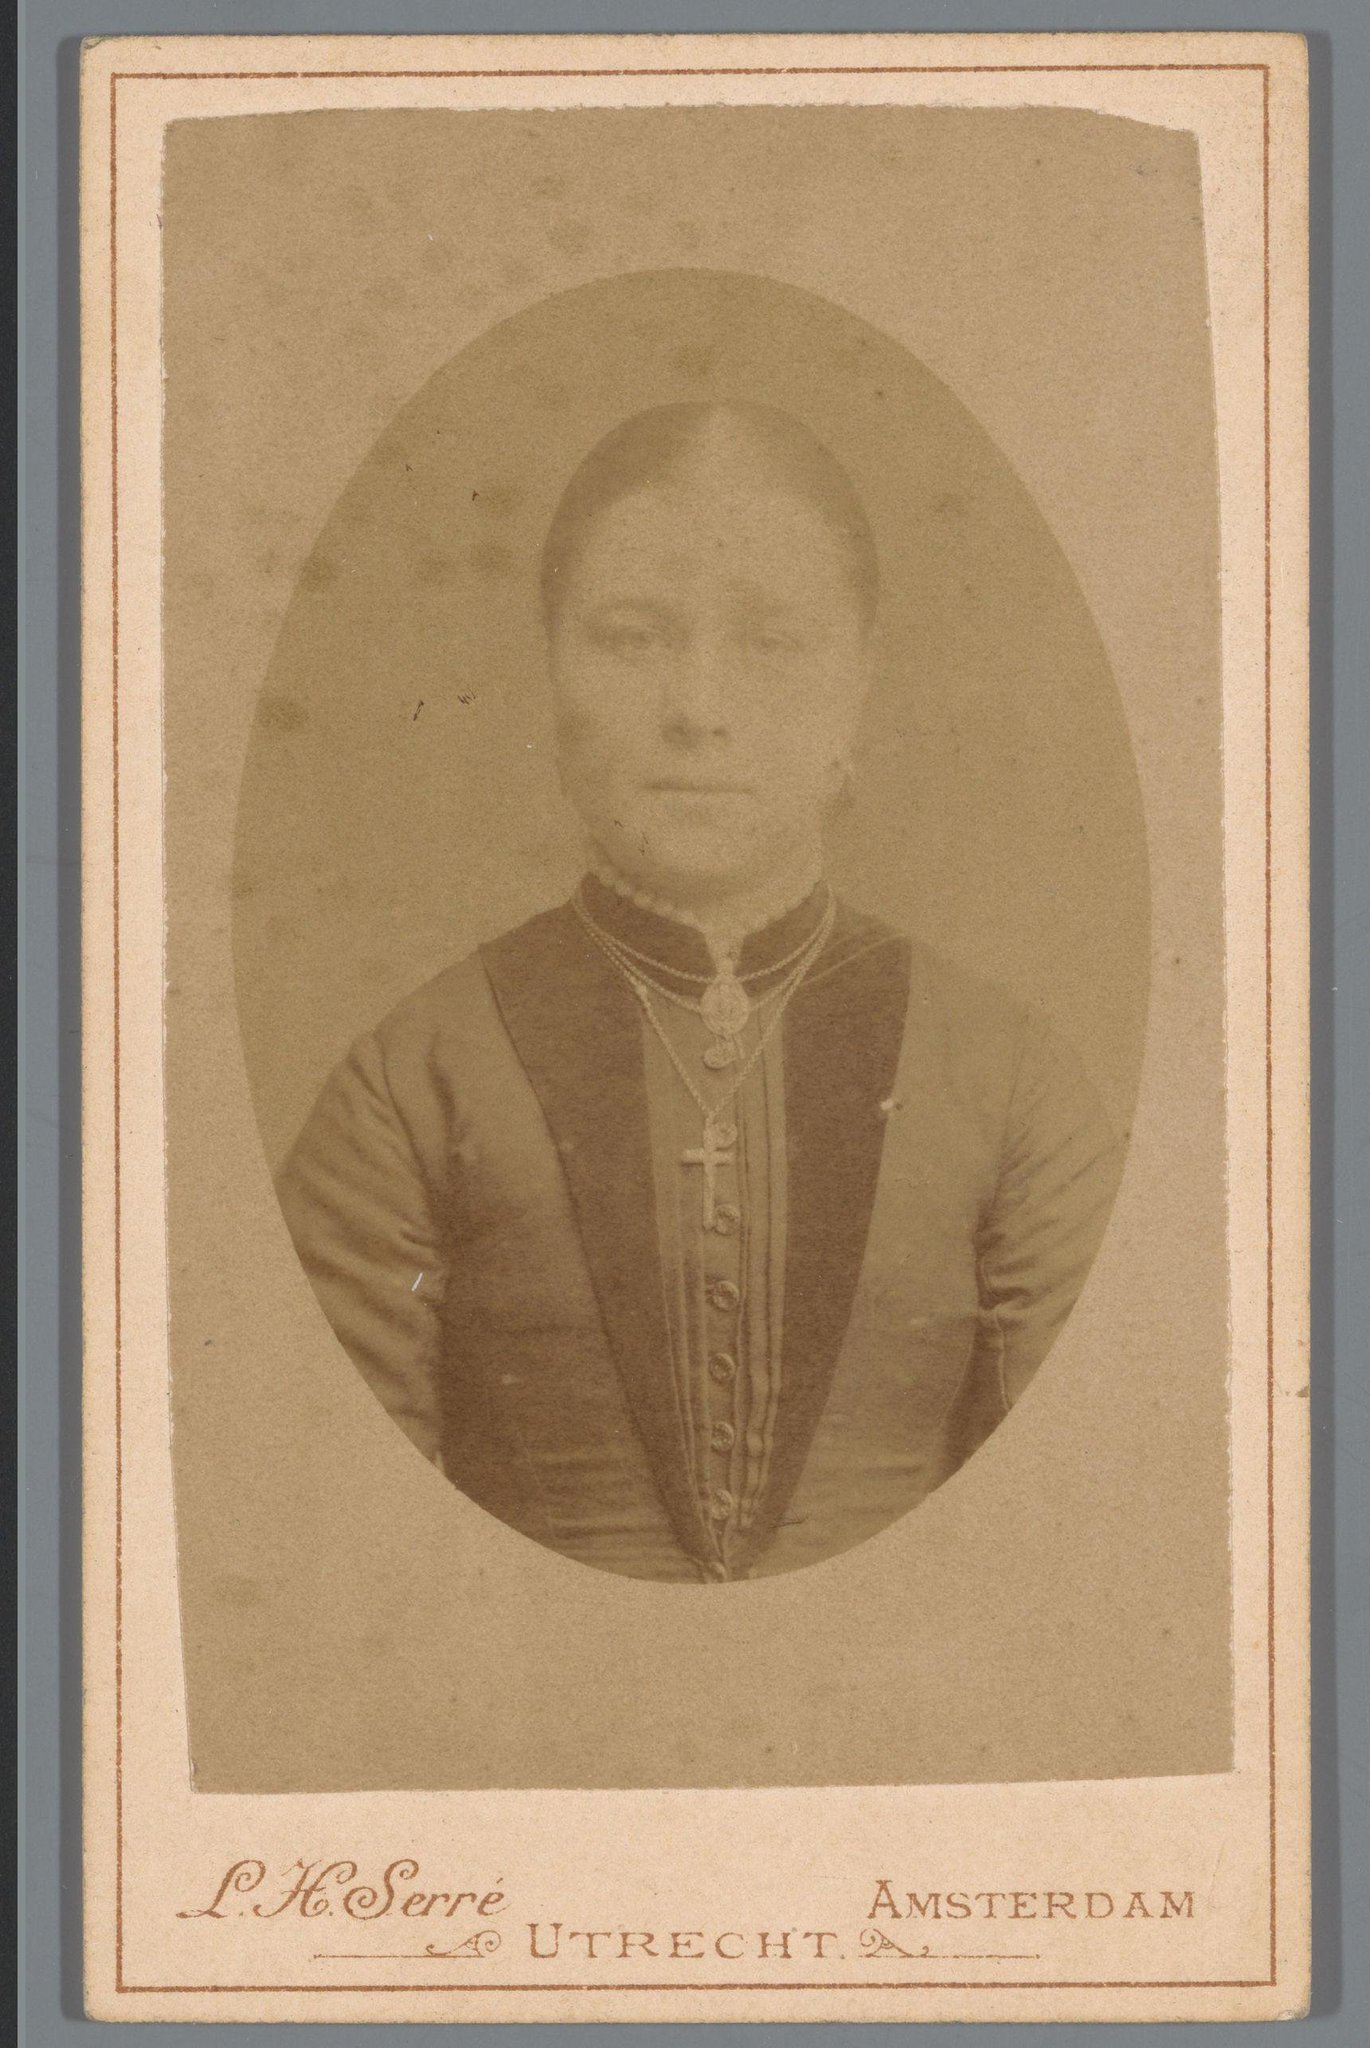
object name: photograph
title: Portret van een onbekende vrouw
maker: lodewijk hendrikus serré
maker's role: fotograaf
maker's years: 1847-1897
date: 1877-1897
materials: cardboard, paper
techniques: albumen print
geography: amsterdam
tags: adult woman, anonymous historical person portrayed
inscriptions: address: ‘Amsterdam/ Damstraat 34./ Utrecht/ 's Hage, Brussel/ en Antwerpen.’